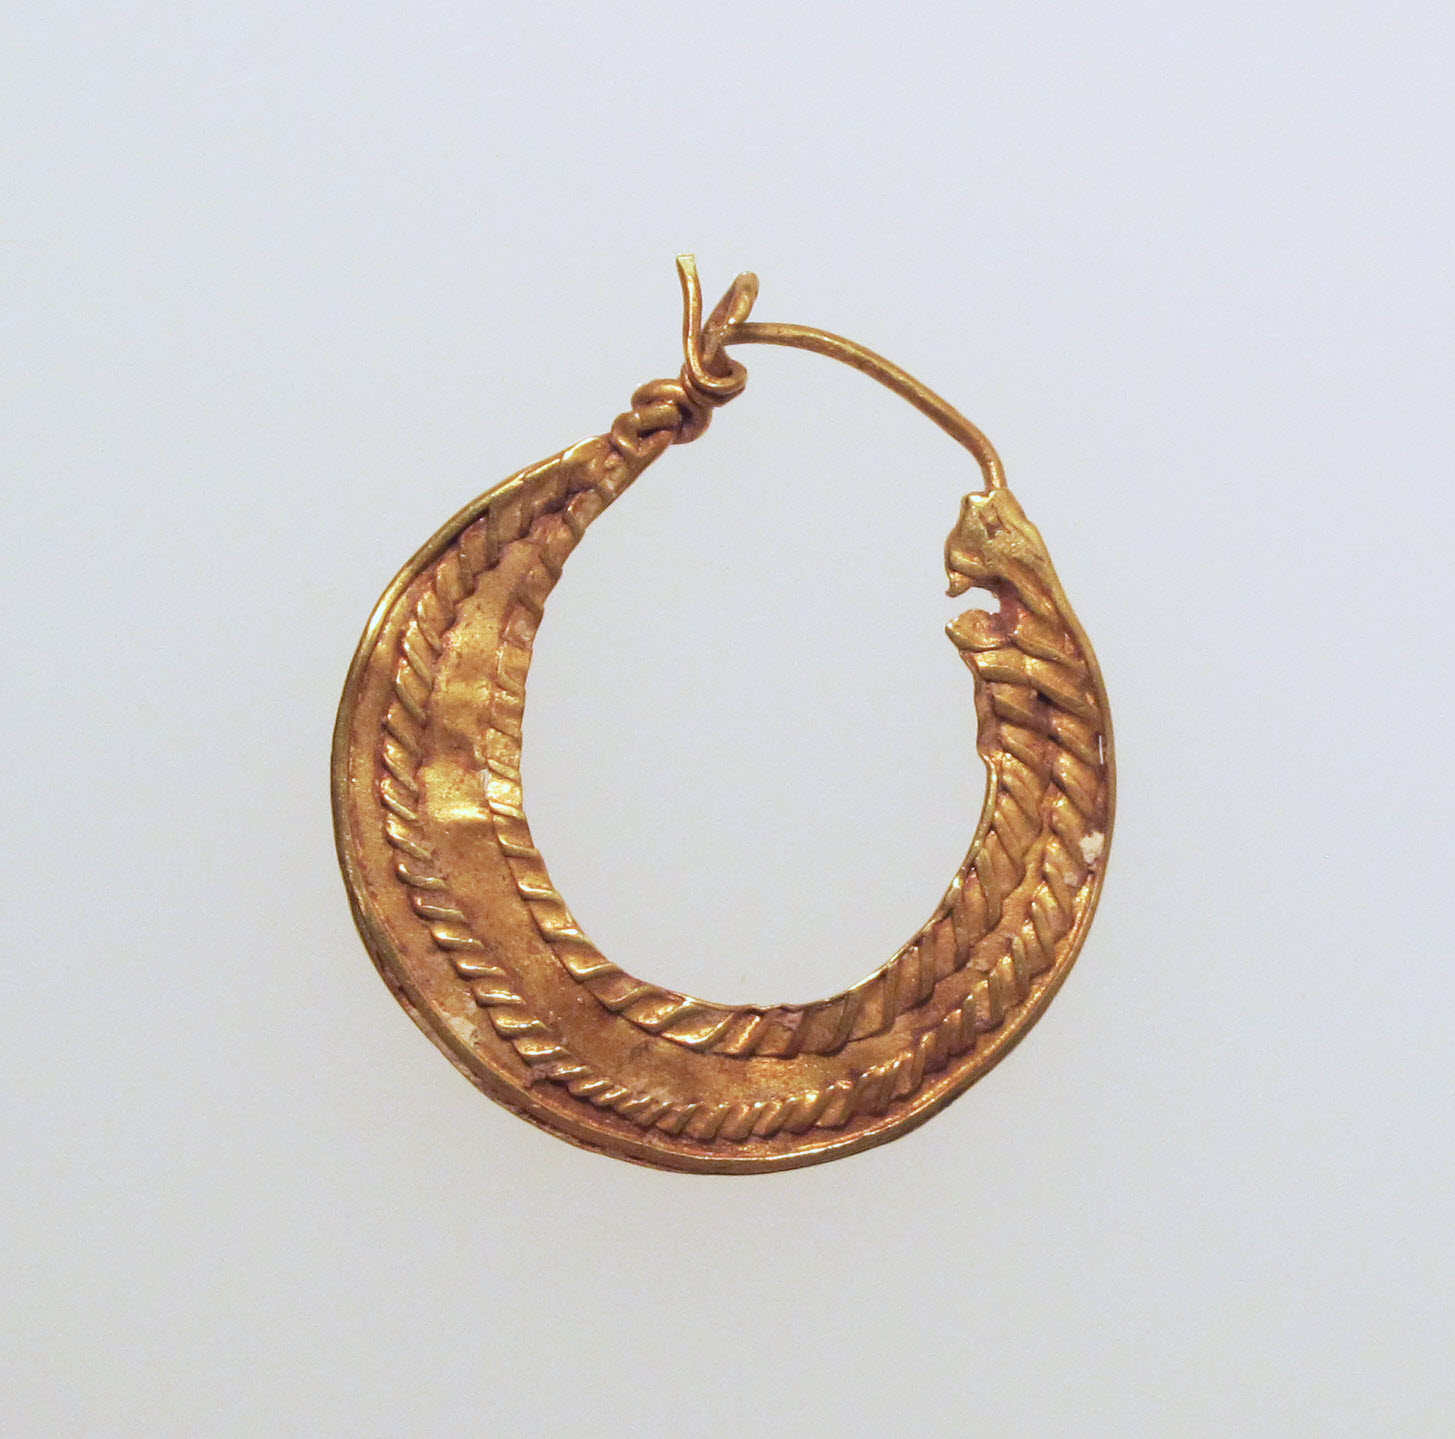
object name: earring, crescent shaped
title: Earring, crescent-shaped, decorated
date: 7000 BCE-330 CE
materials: gold